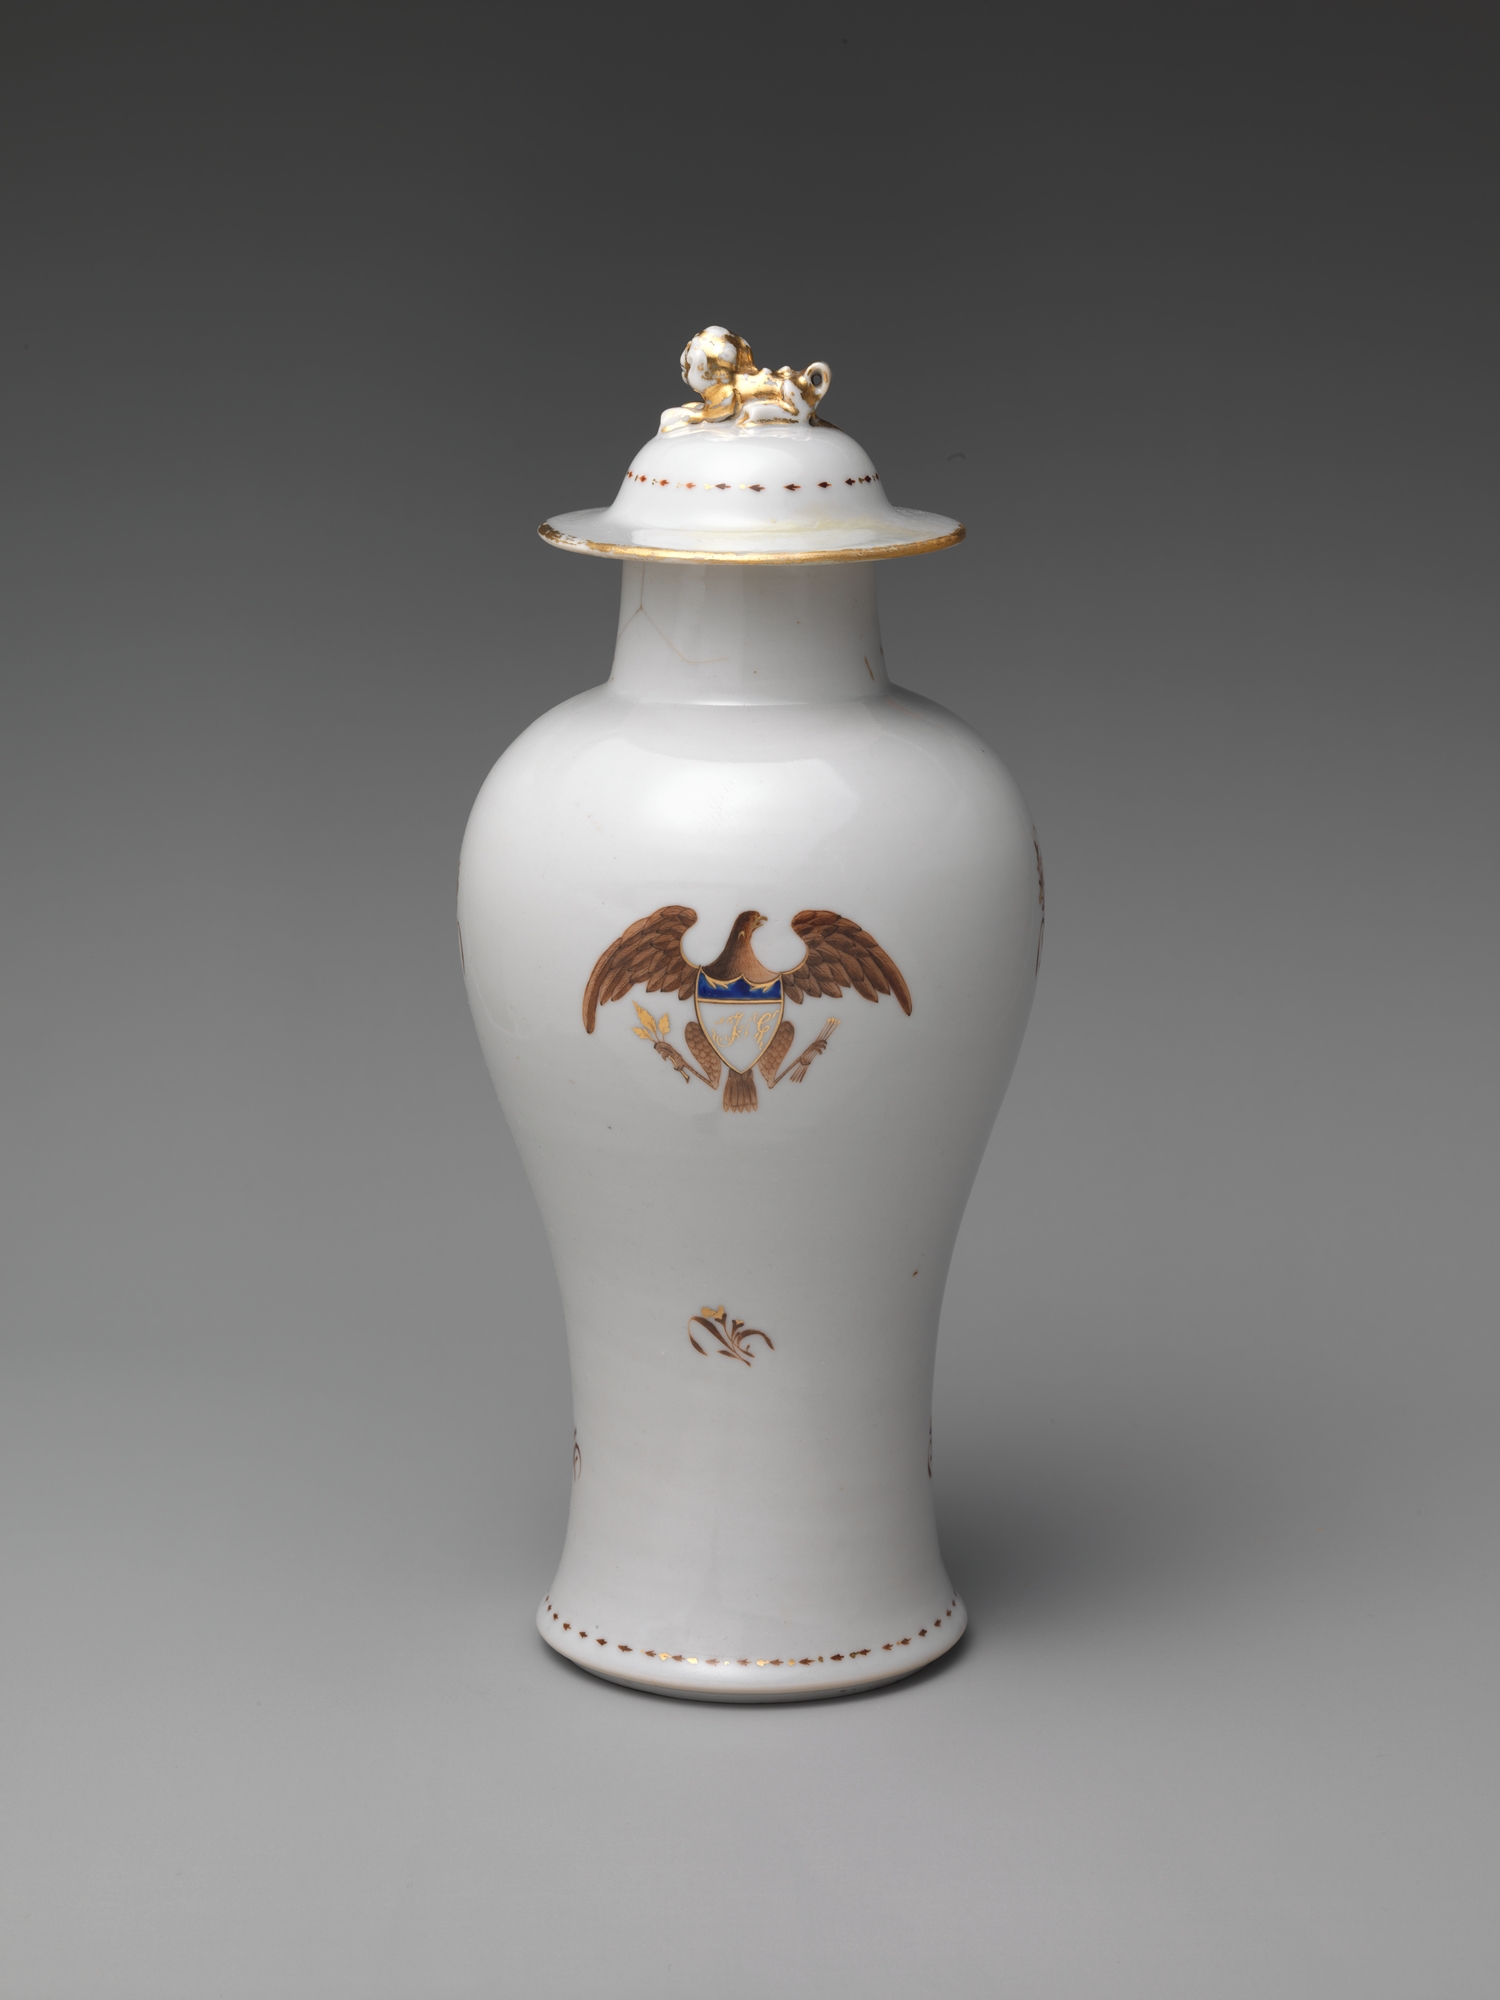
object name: vase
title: Covered Vase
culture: chinese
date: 1790-1800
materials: porcelain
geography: china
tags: eagles